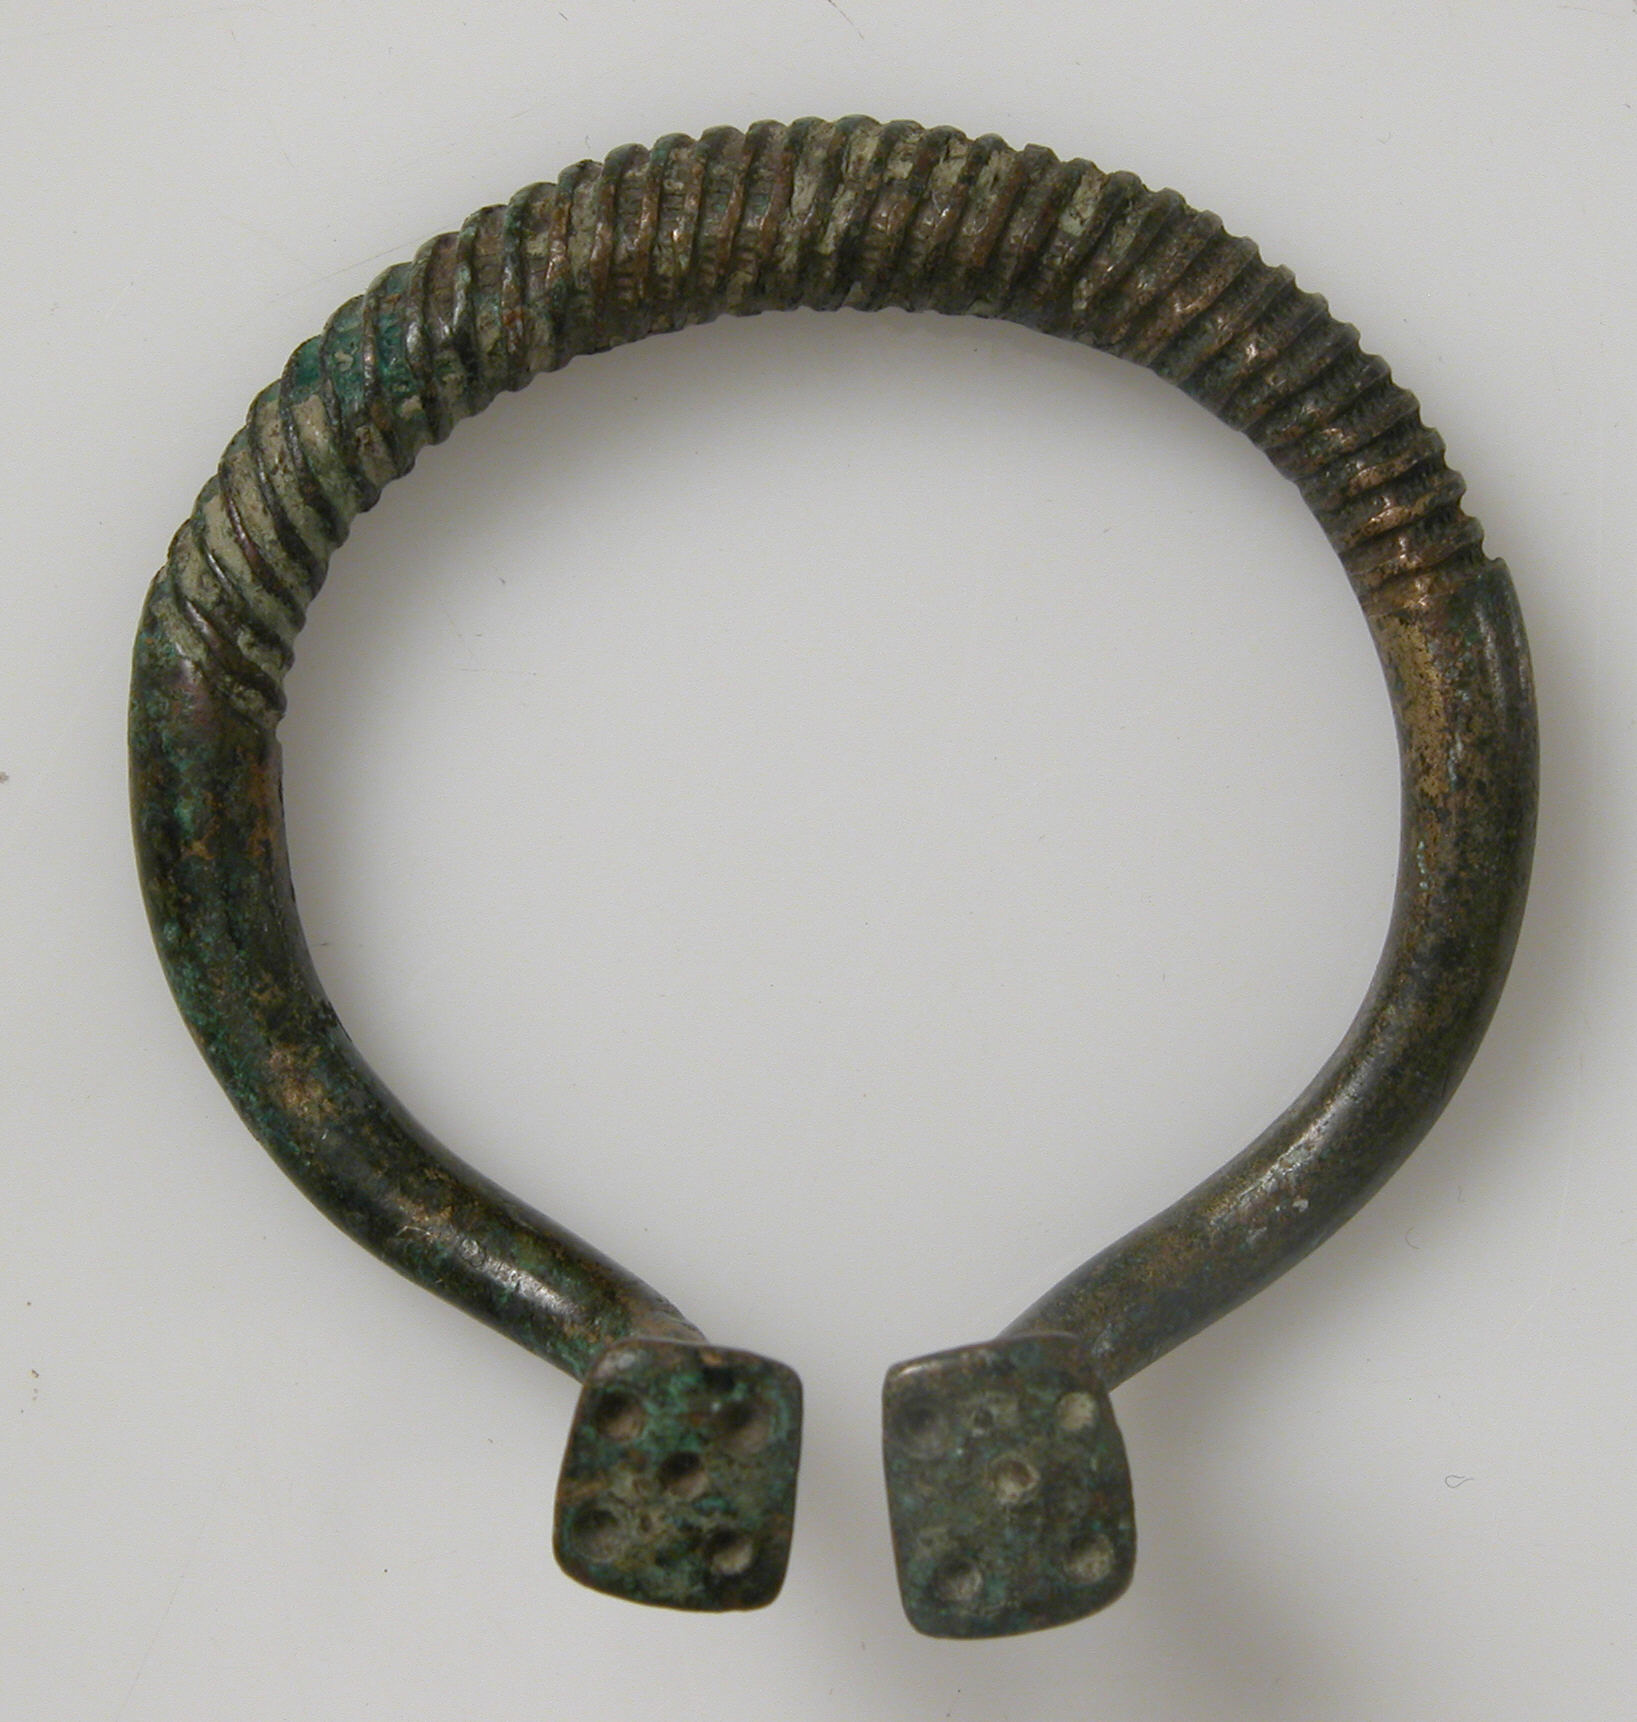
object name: brooch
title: Ring from a Pennanular Brooch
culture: anglo-saxon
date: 801-900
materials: bronze